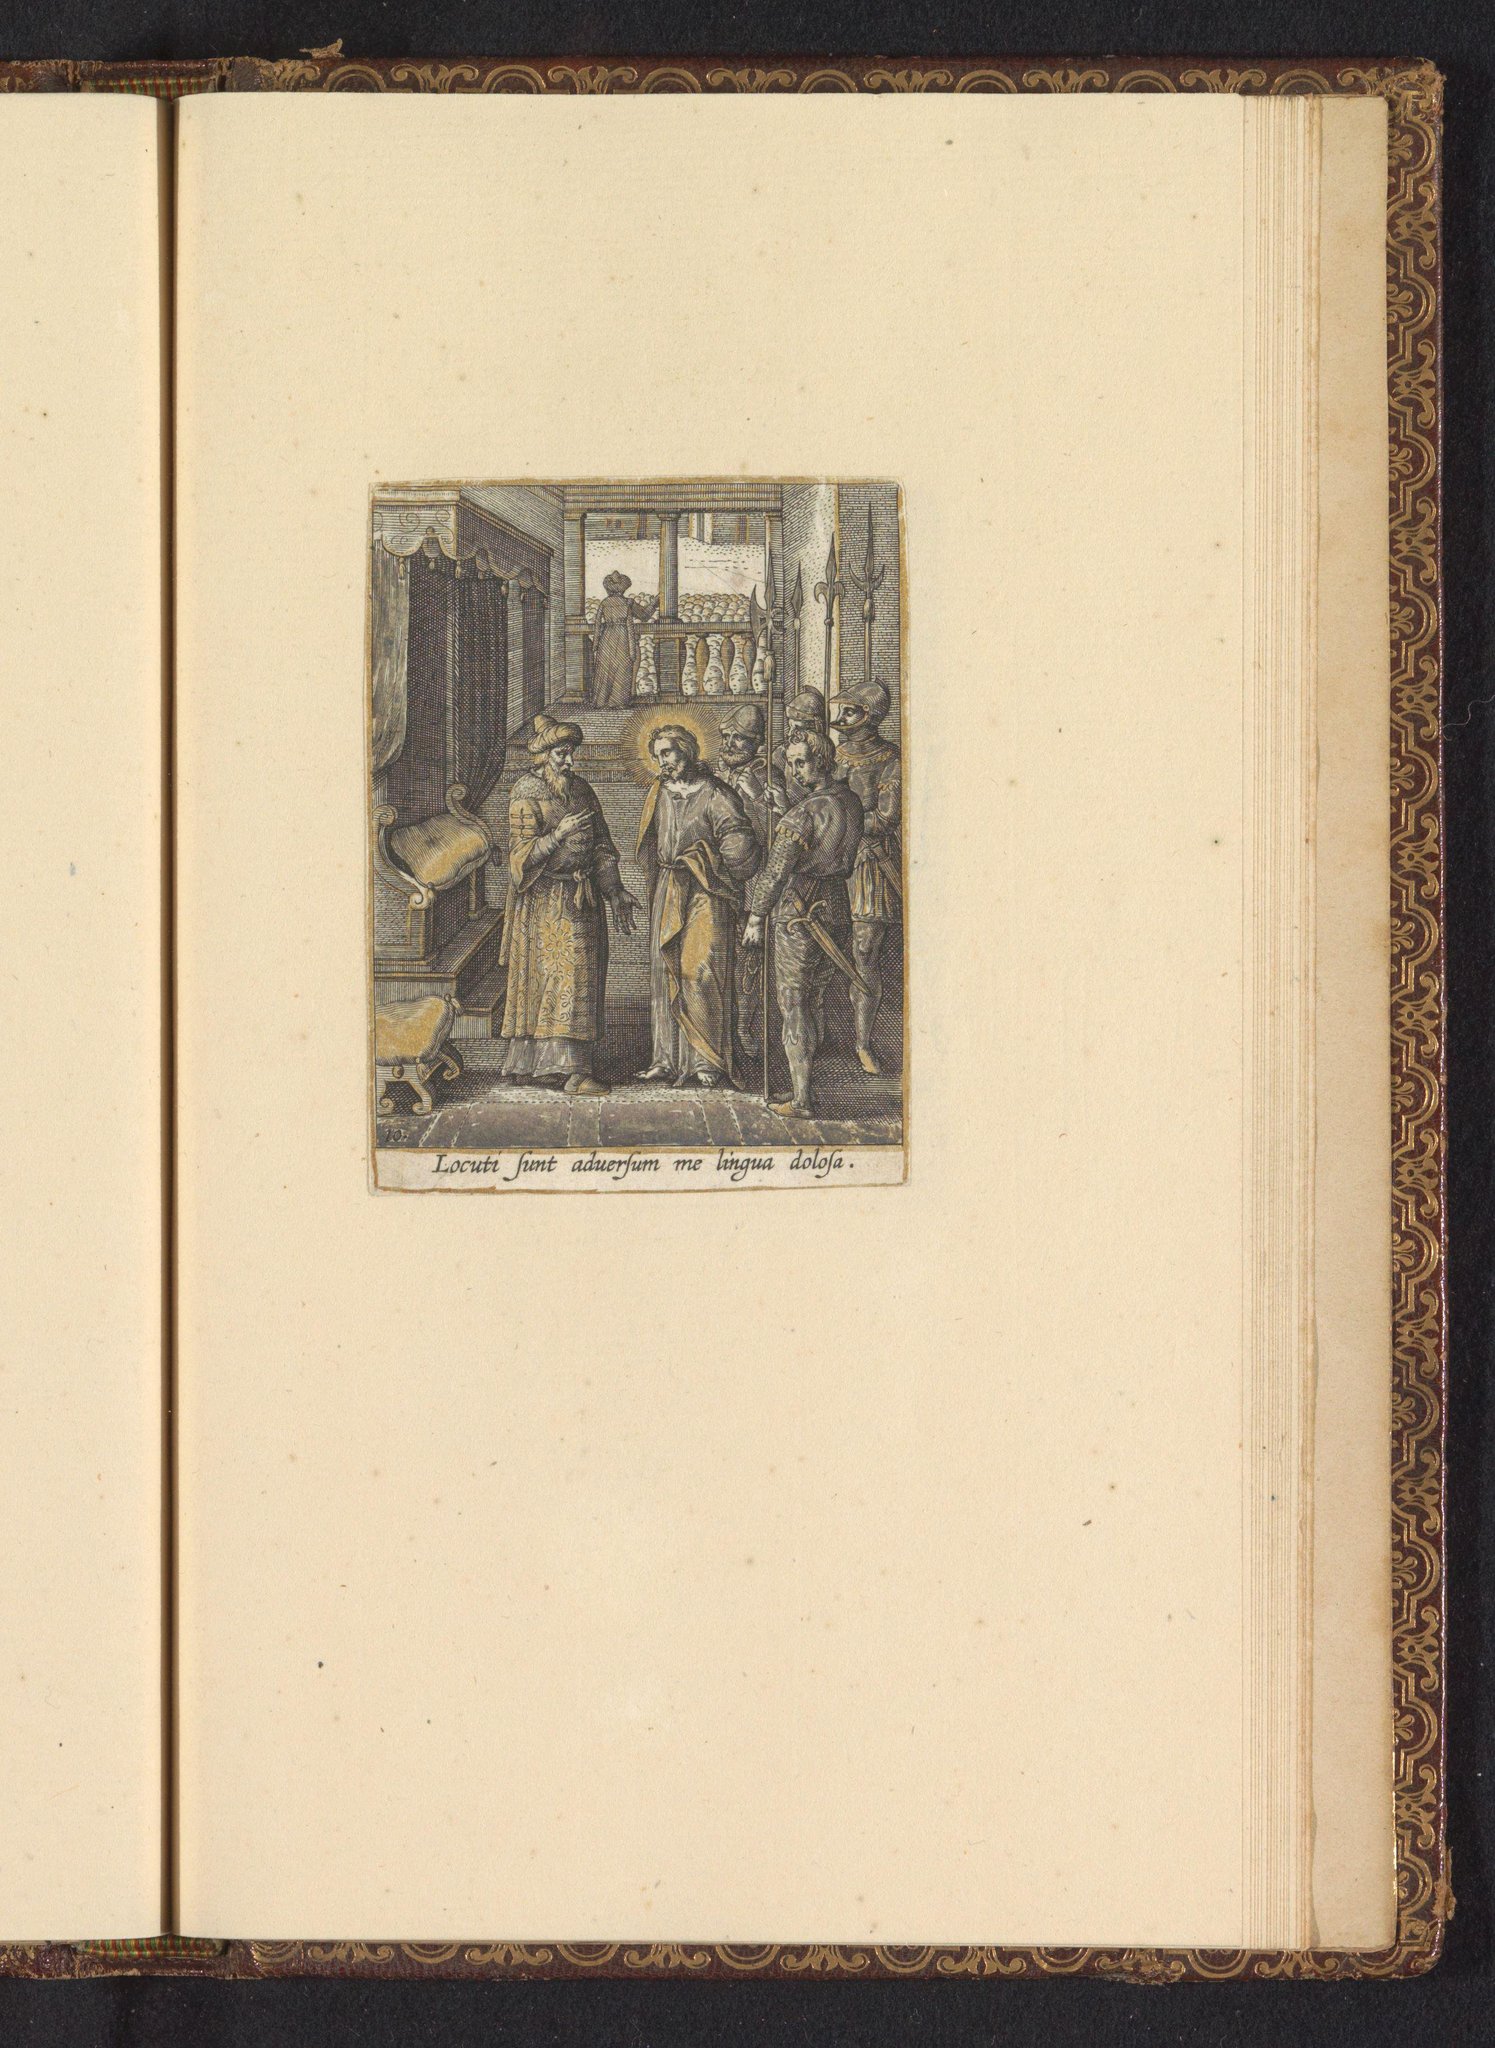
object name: print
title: Christus terug bij Pilatus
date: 1580-1590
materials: gold, paper, silver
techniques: engraving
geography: antwerp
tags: christ before pontius pilate (matthew 27:11-26; mark 15:2-15; luke 23:2-7, 23:13-25; john 18:28 - 19:16)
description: Christus terug bij Pilatus. Onderdeel van de prentserie over de passie van Christus: Passio et resurrectio D.N. Iesu Christi. Edita et excusa ab Ad. Collaert. In prentalbum met twee reeksen van respectievelijk 34 en 24 gravures met scènes uit het leven en het lijdensverhaal van Christus.